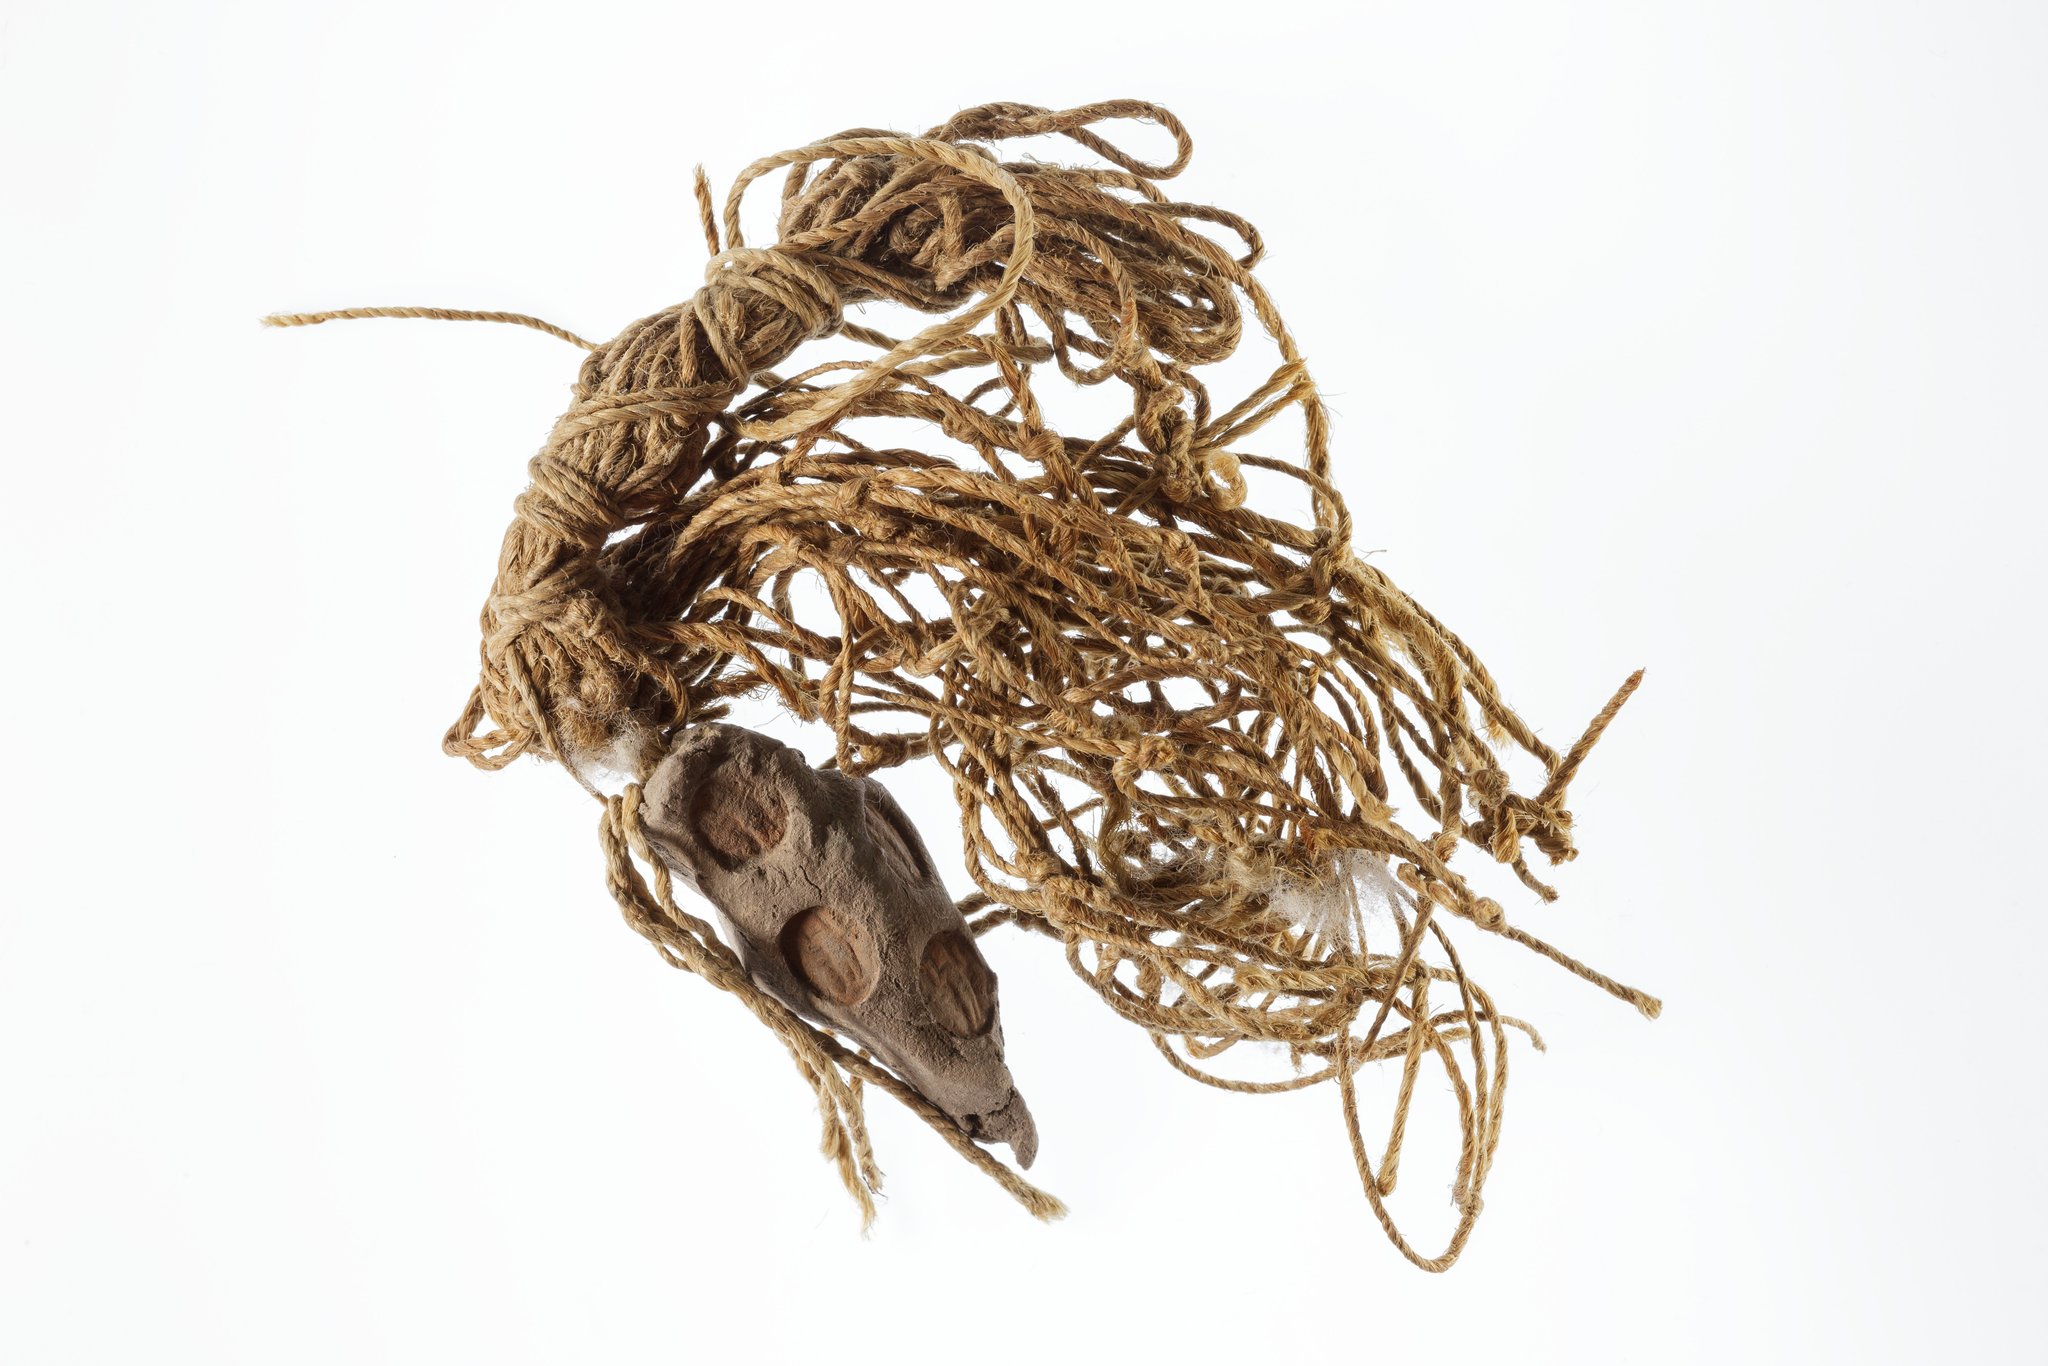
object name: sealing, from net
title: Sealing from net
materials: cord, mud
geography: egypt